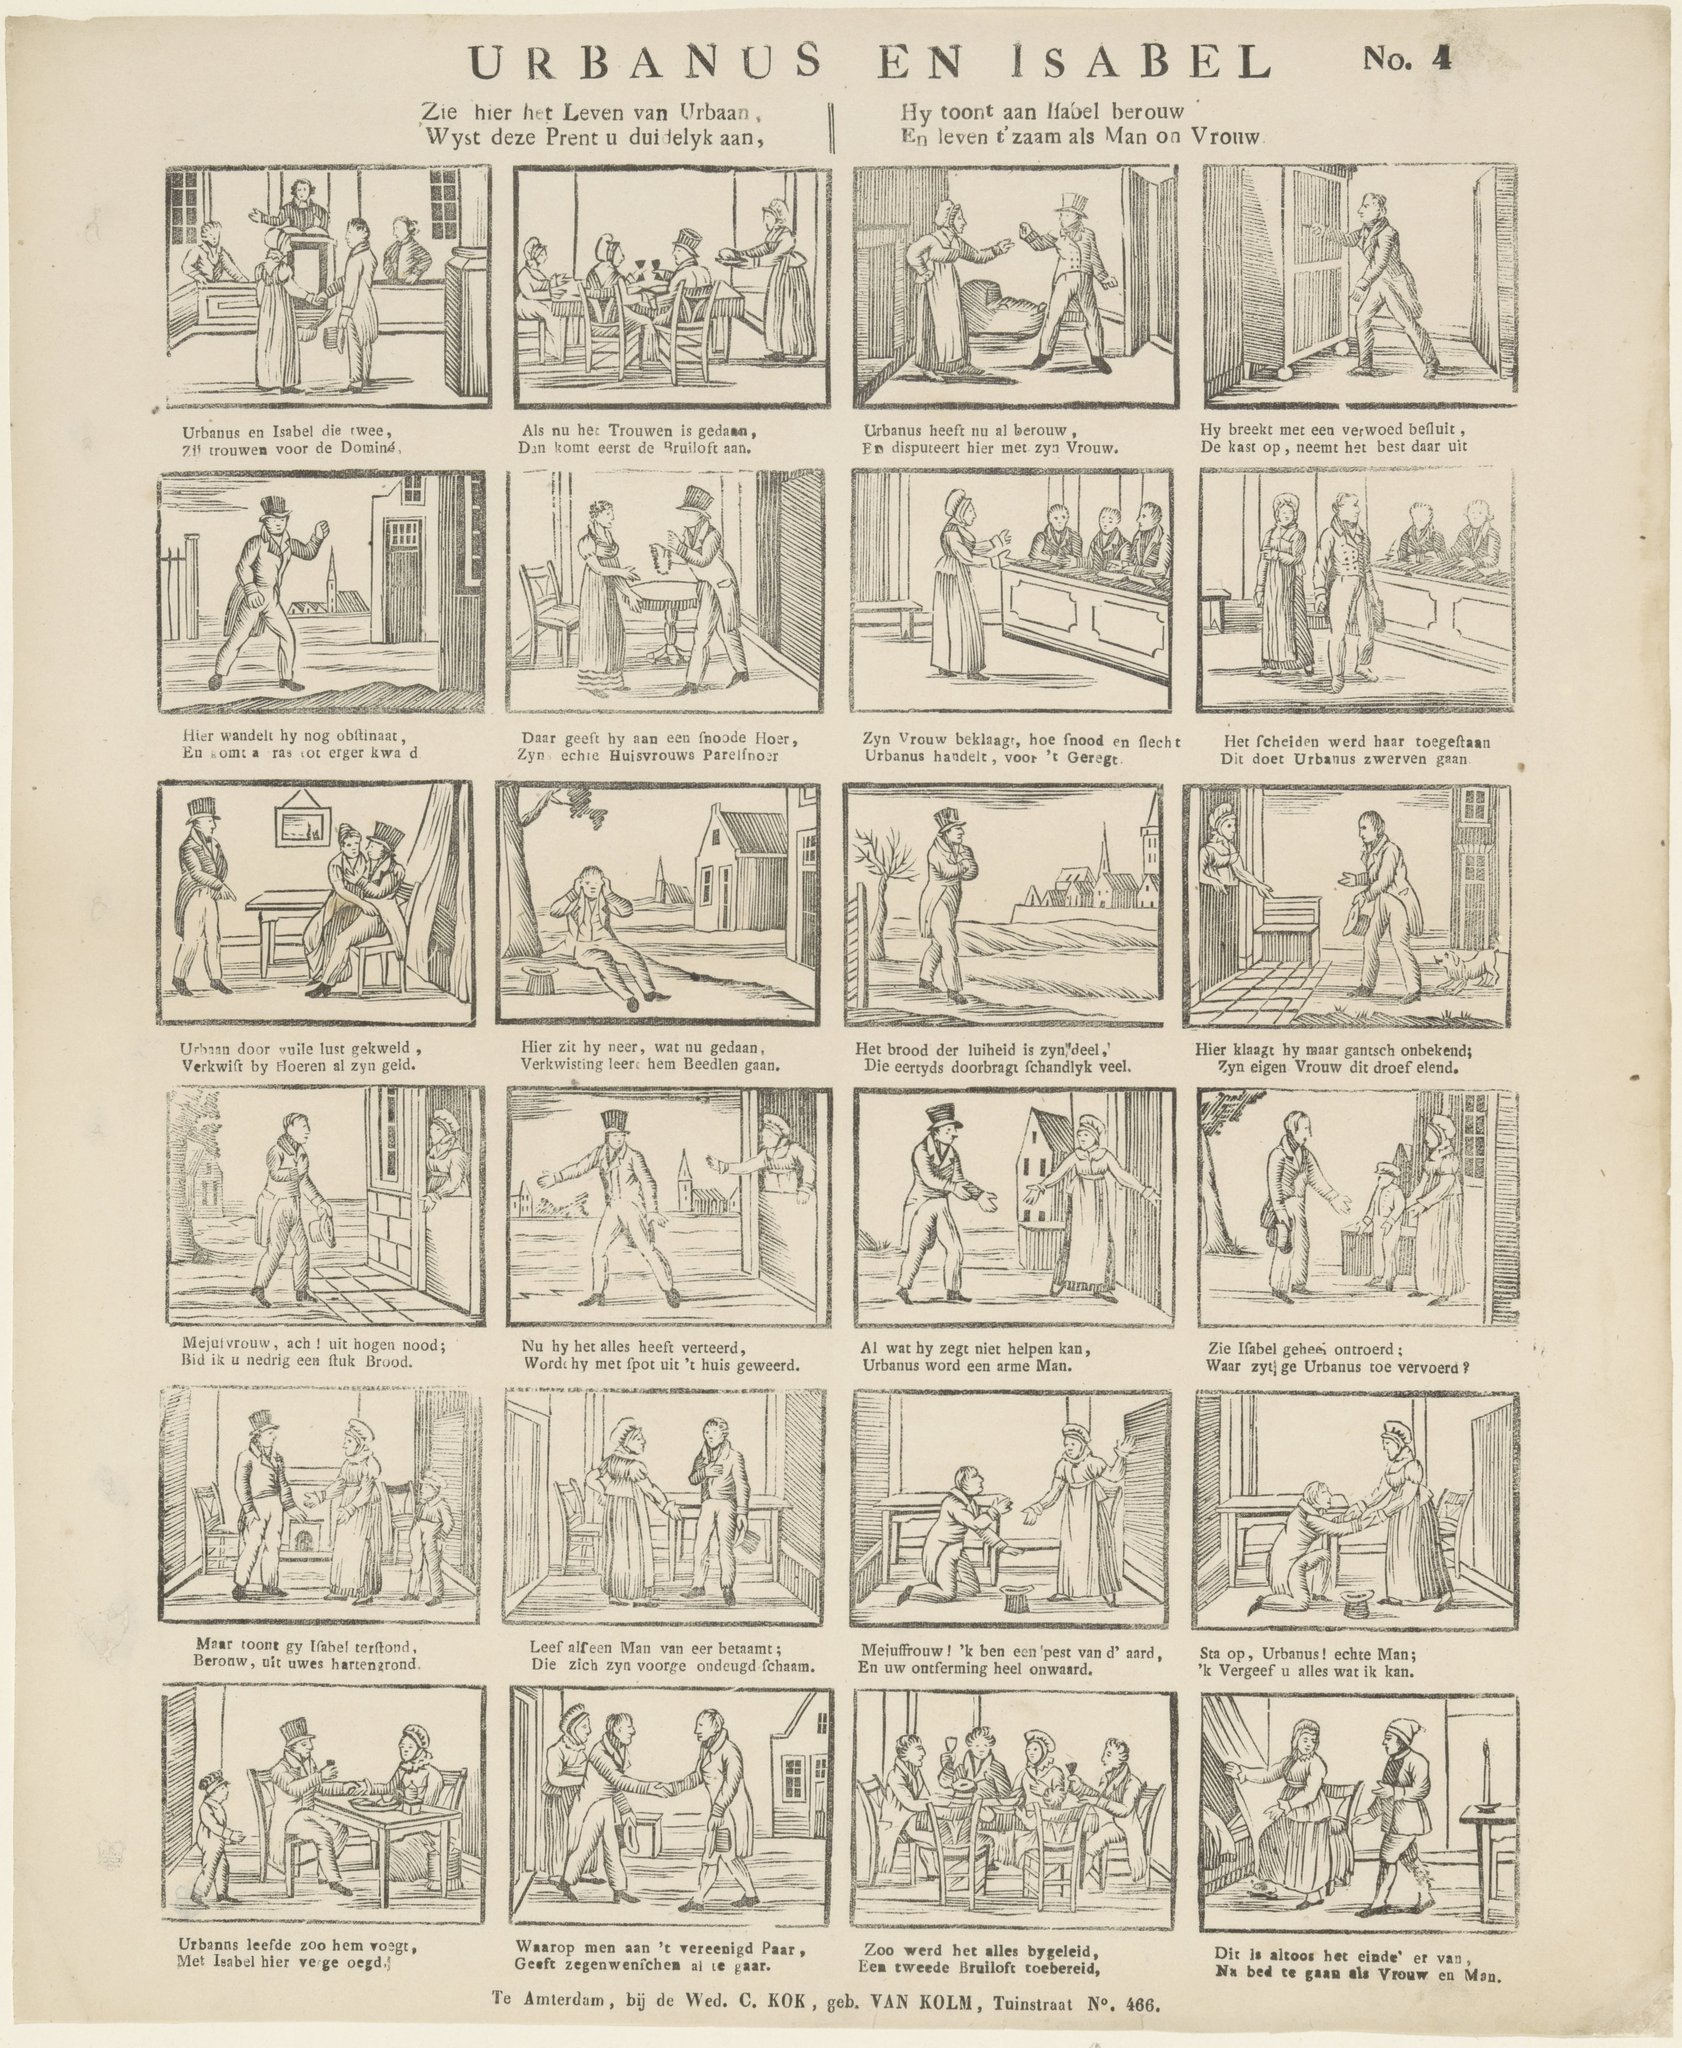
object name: popular print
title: Urbanus en Isabel / Zie hier het leven van Urbaan (...)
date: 1842-1866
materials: paper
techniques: letterpress printing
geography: amsterdam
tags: divorce, beggar, man and wife quarrelling, 'marriage à la mode'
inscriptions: collector's mark: Lugt 2760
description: Blad met 24 voorstellingen uit het leven van Urbanus en Isabel. Ze trouwen, maken ruzie, gaan scheiden, en Urbanus wordt een bedelaar. Onder elke afbeelding een tweeregelig vers. Genummerd rechtsboven: No. 4.